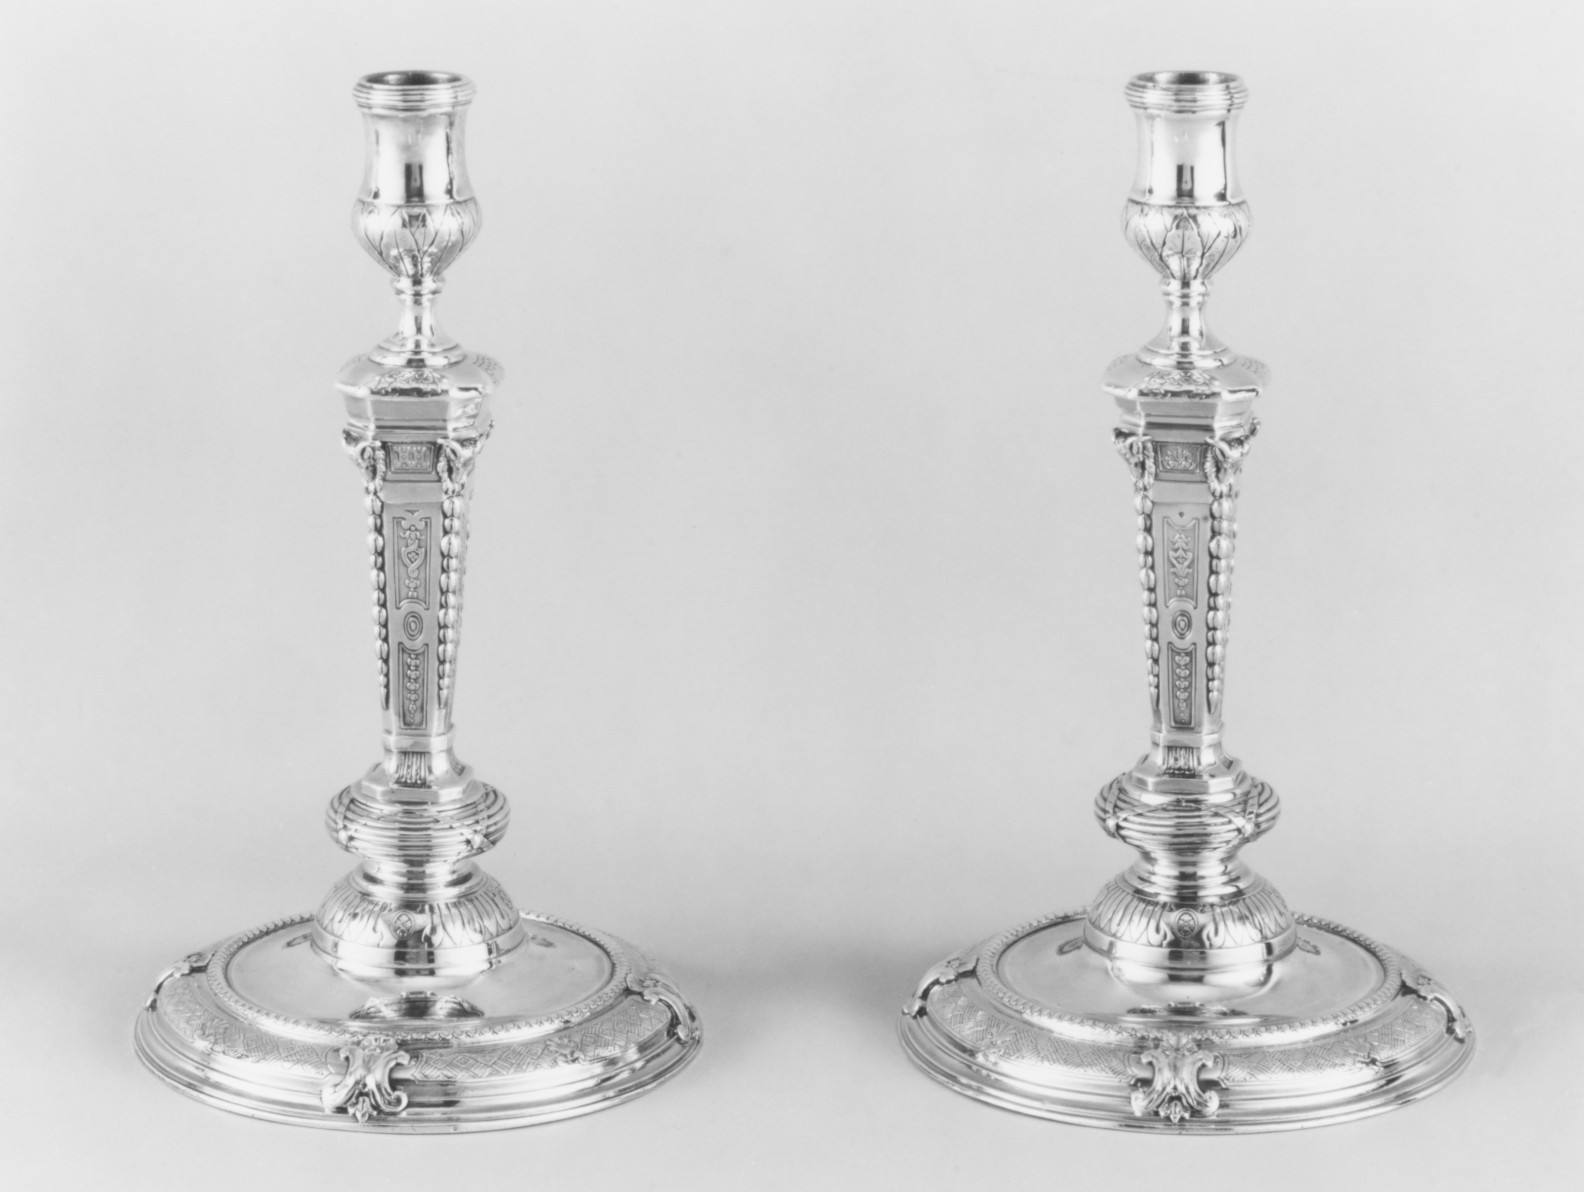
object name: candlestick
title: Pair of candlesticks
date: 1724-1727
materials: silver